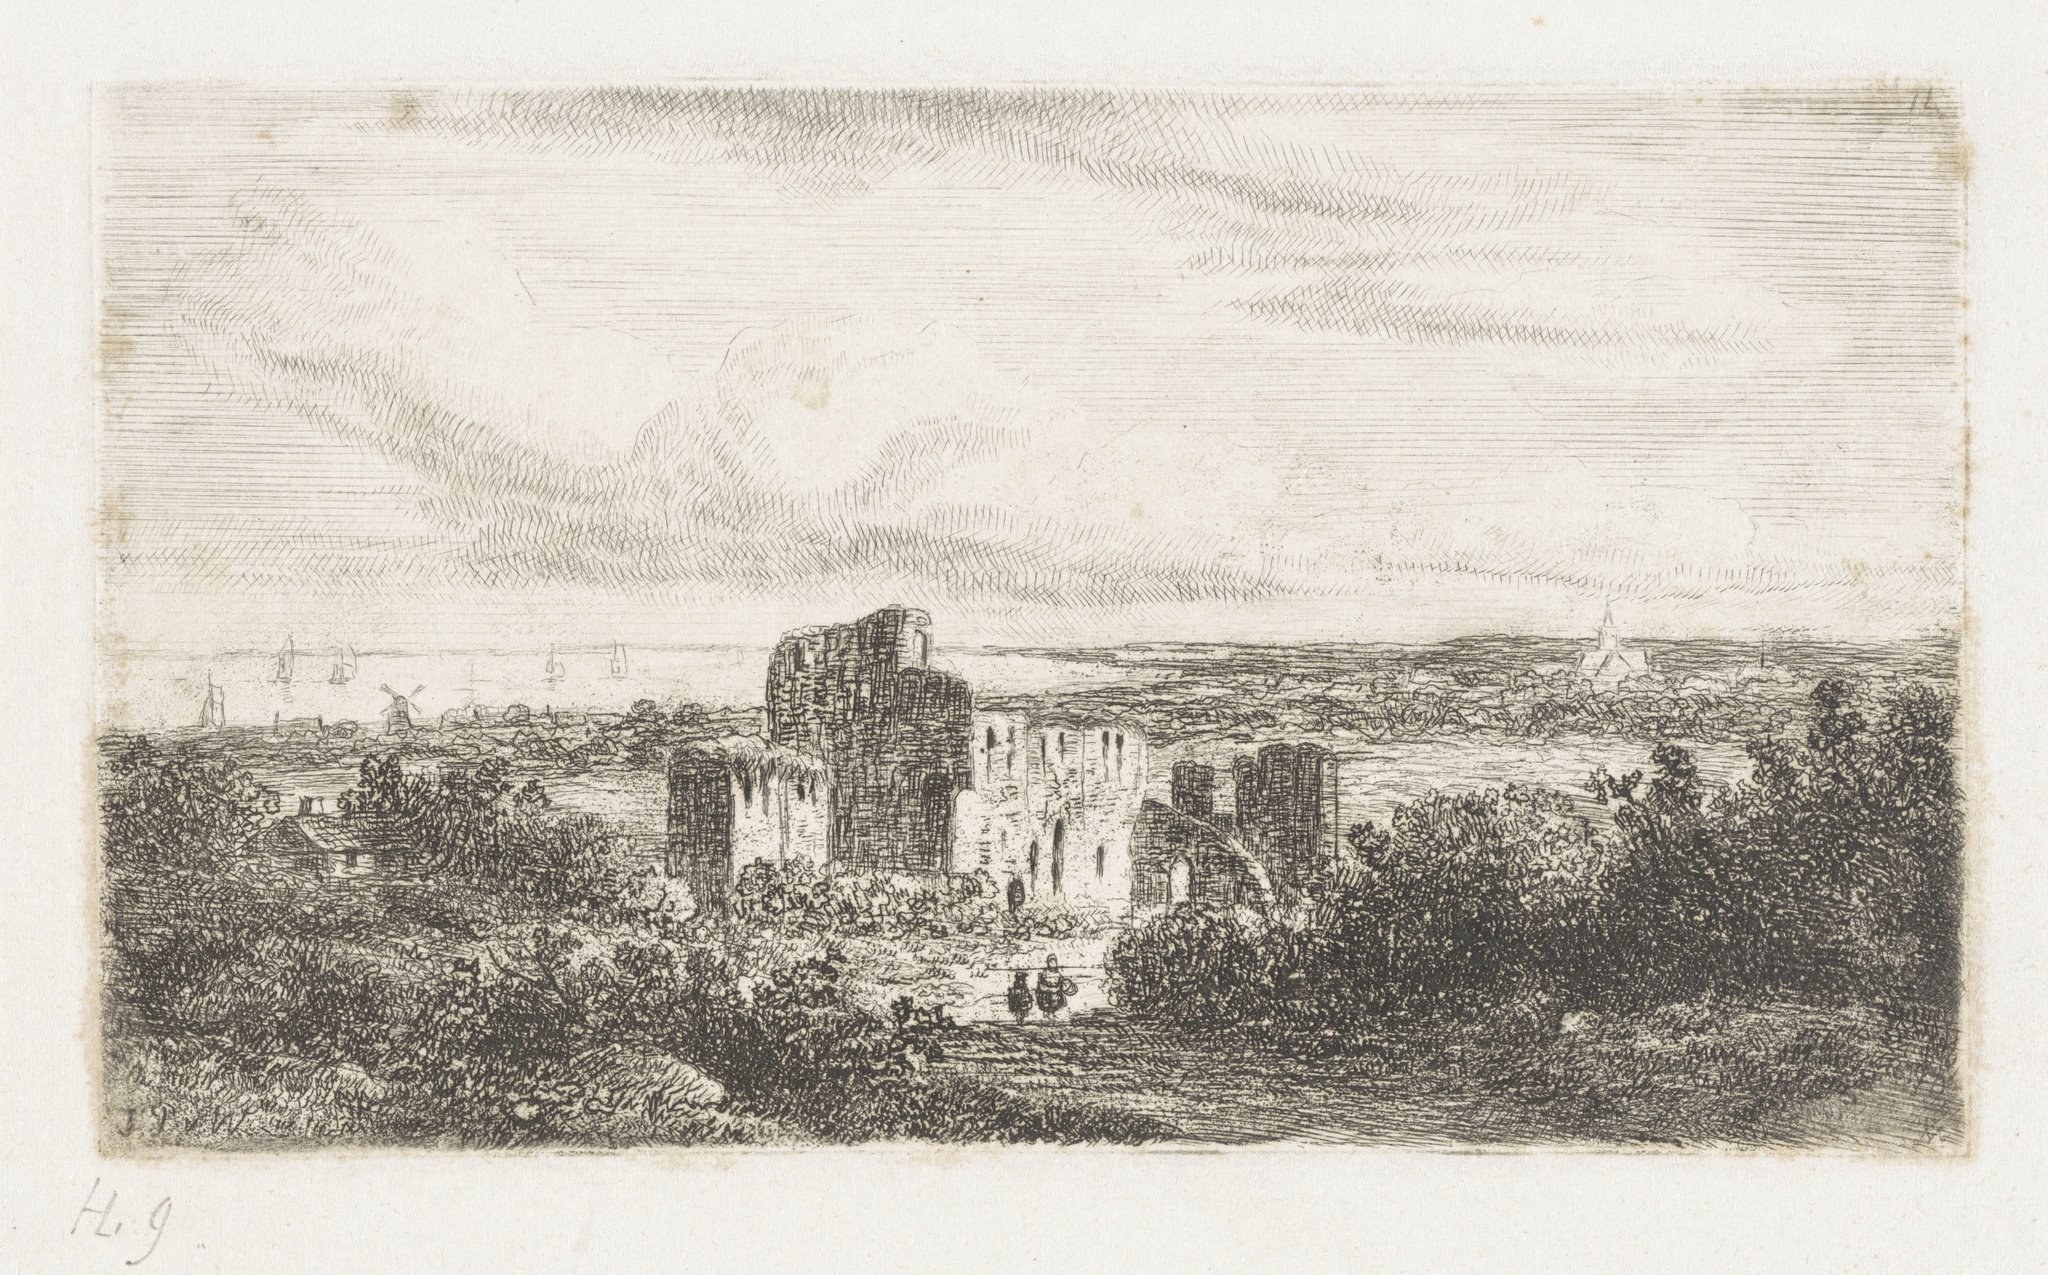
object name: print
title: Kustlandschap met ruïne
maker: johannes pieter van wisselingh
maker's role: draughtsman, painter, print maker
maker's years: 1812-1899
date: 1830-1878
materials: paper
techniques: etching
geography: netherlands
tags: dune coast, sailing-ship, sailing-boat, ruin of a building ~ architecture, landscape with ruins, church (exterior) - qq - small church, chapel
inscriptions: collector's mark: Lugt 2228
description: In de duinen ligt een ruïne. Rechts in de verte staat een kleine kerk. Links in de verte de zee met enkele zeilschepen. Rechtsboven het getal 14.